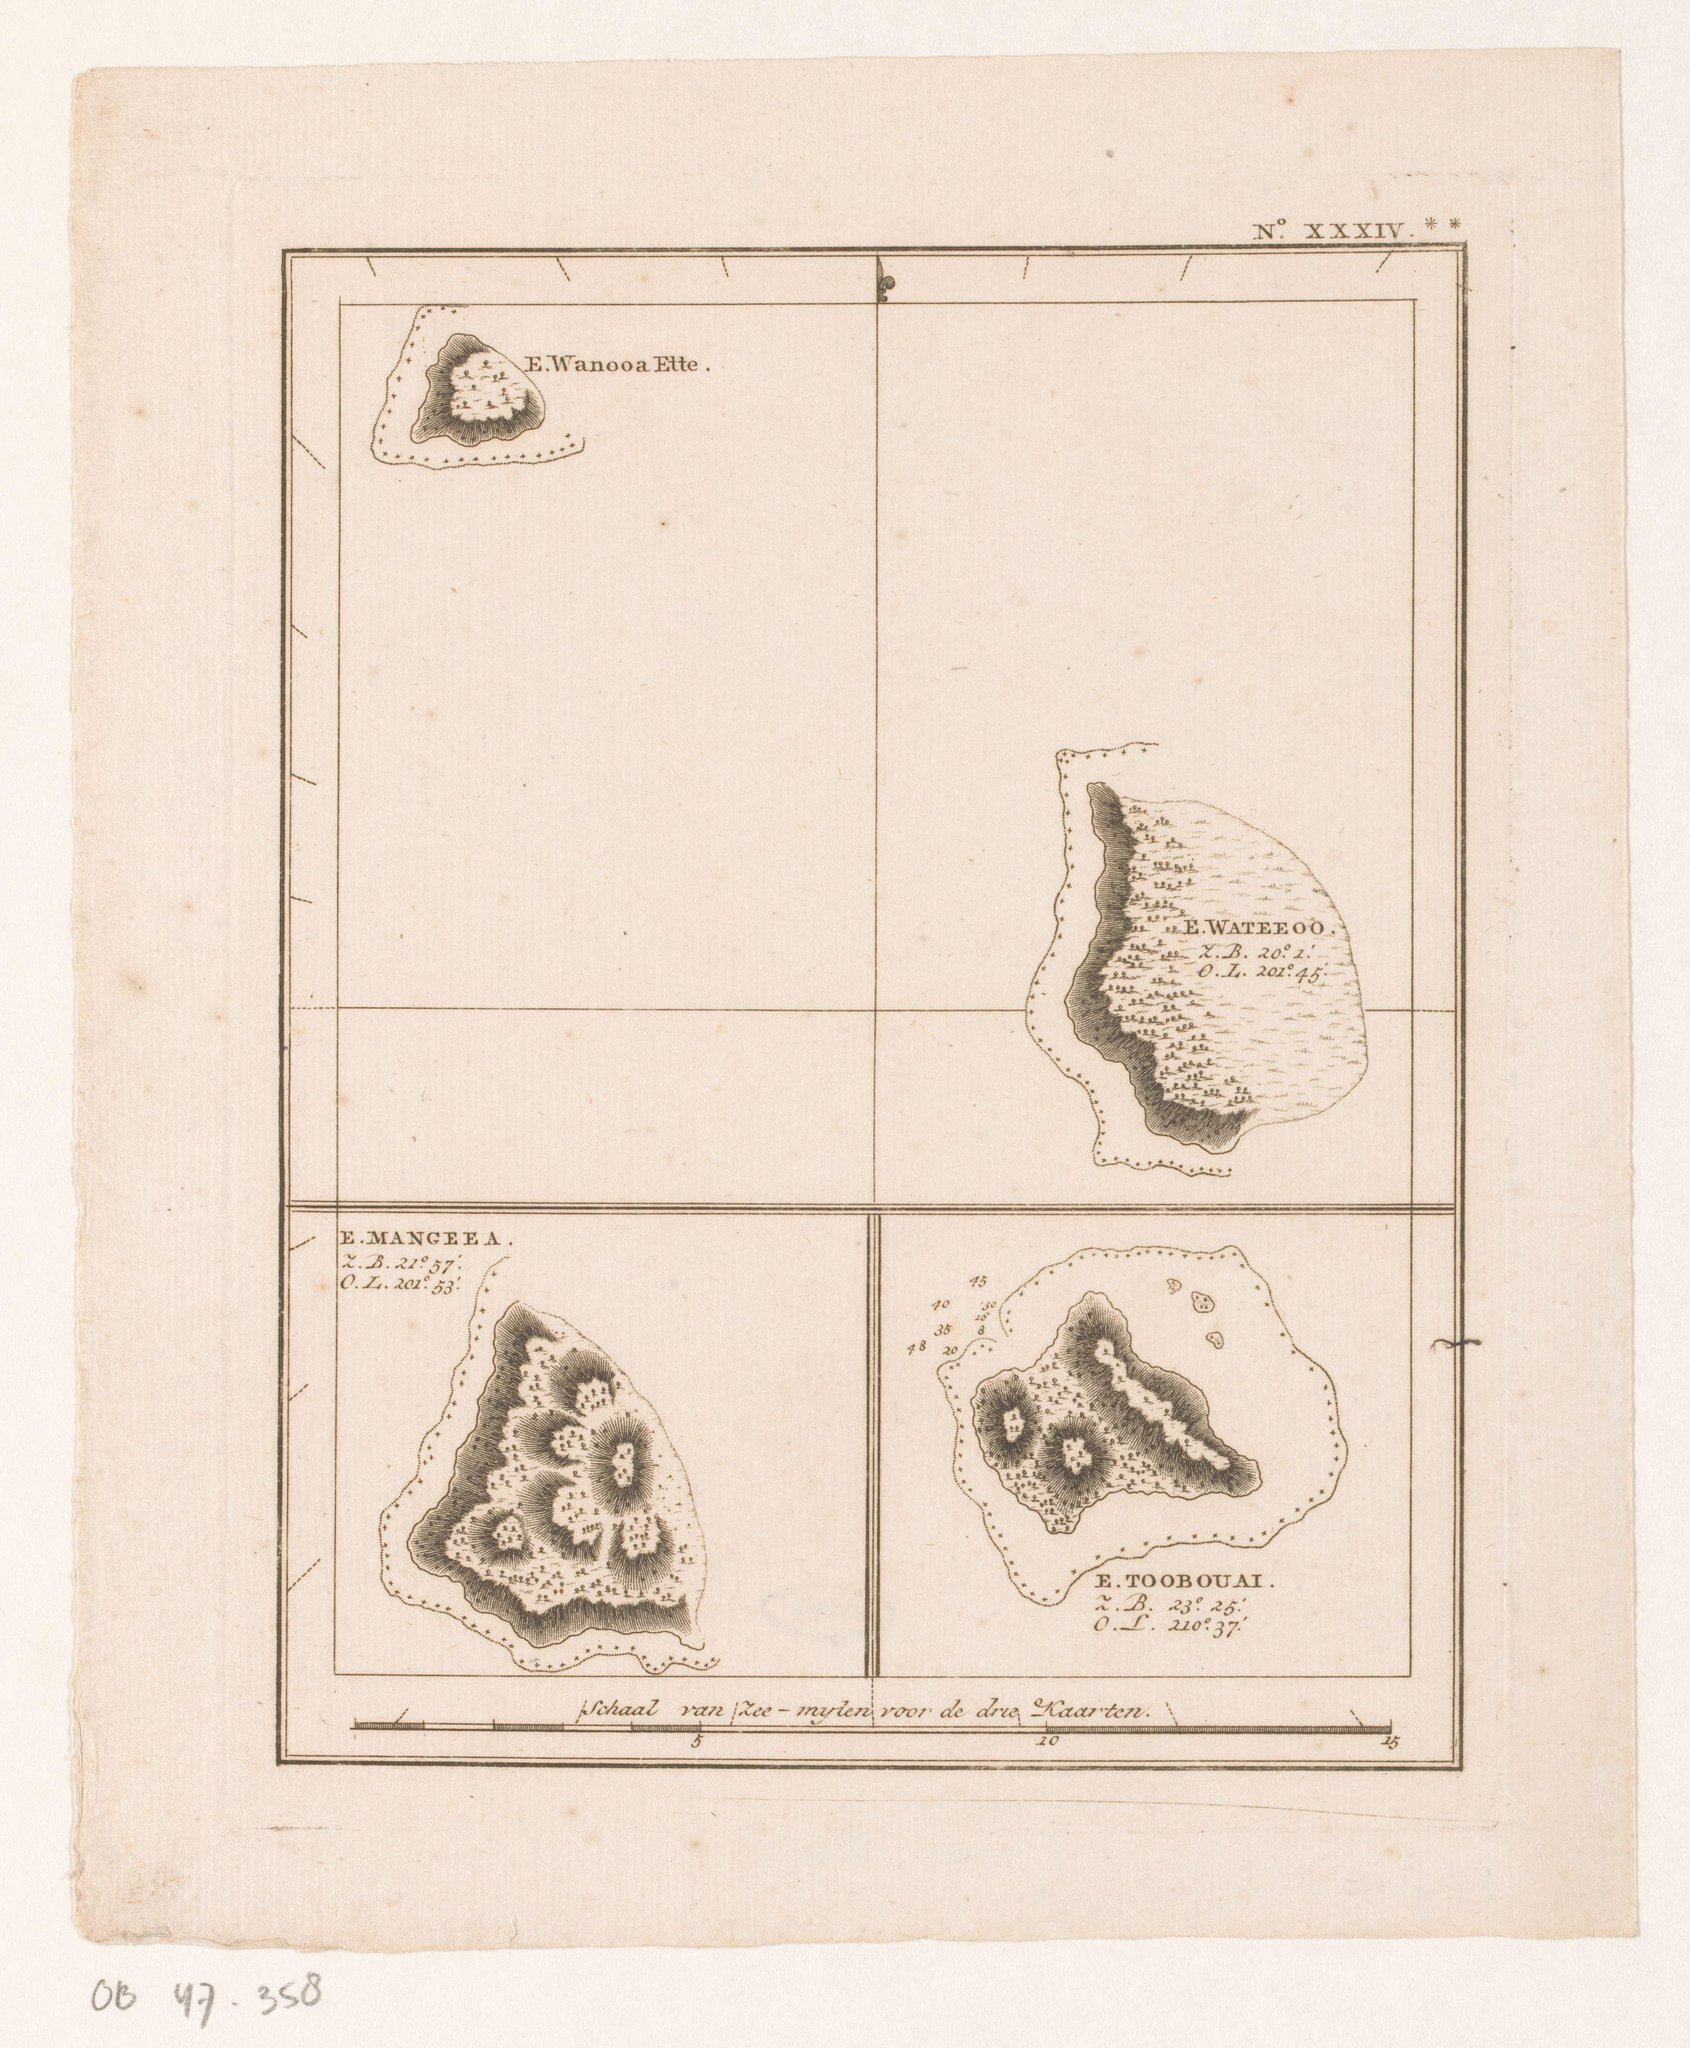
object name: book illustration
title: Kaart van vier eilanden in de Grote Oceaan, waaronder Mangaia en Tubuai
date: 1802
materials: paper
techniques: etching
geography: leiden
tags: island, maps, atlases, french polynesia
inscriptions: collector's mark: Lugt 2228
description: Prent uit: Cook, James. Reize rondom de Waereld (...) met kaarten en plaaten. [Vertaald uit het Engels door] Jan David Pasteur. Leiden: Honkoop, Amsterdam: Allart, Den Haag: Van Cleef, 1802, dl. 10, p. 6.